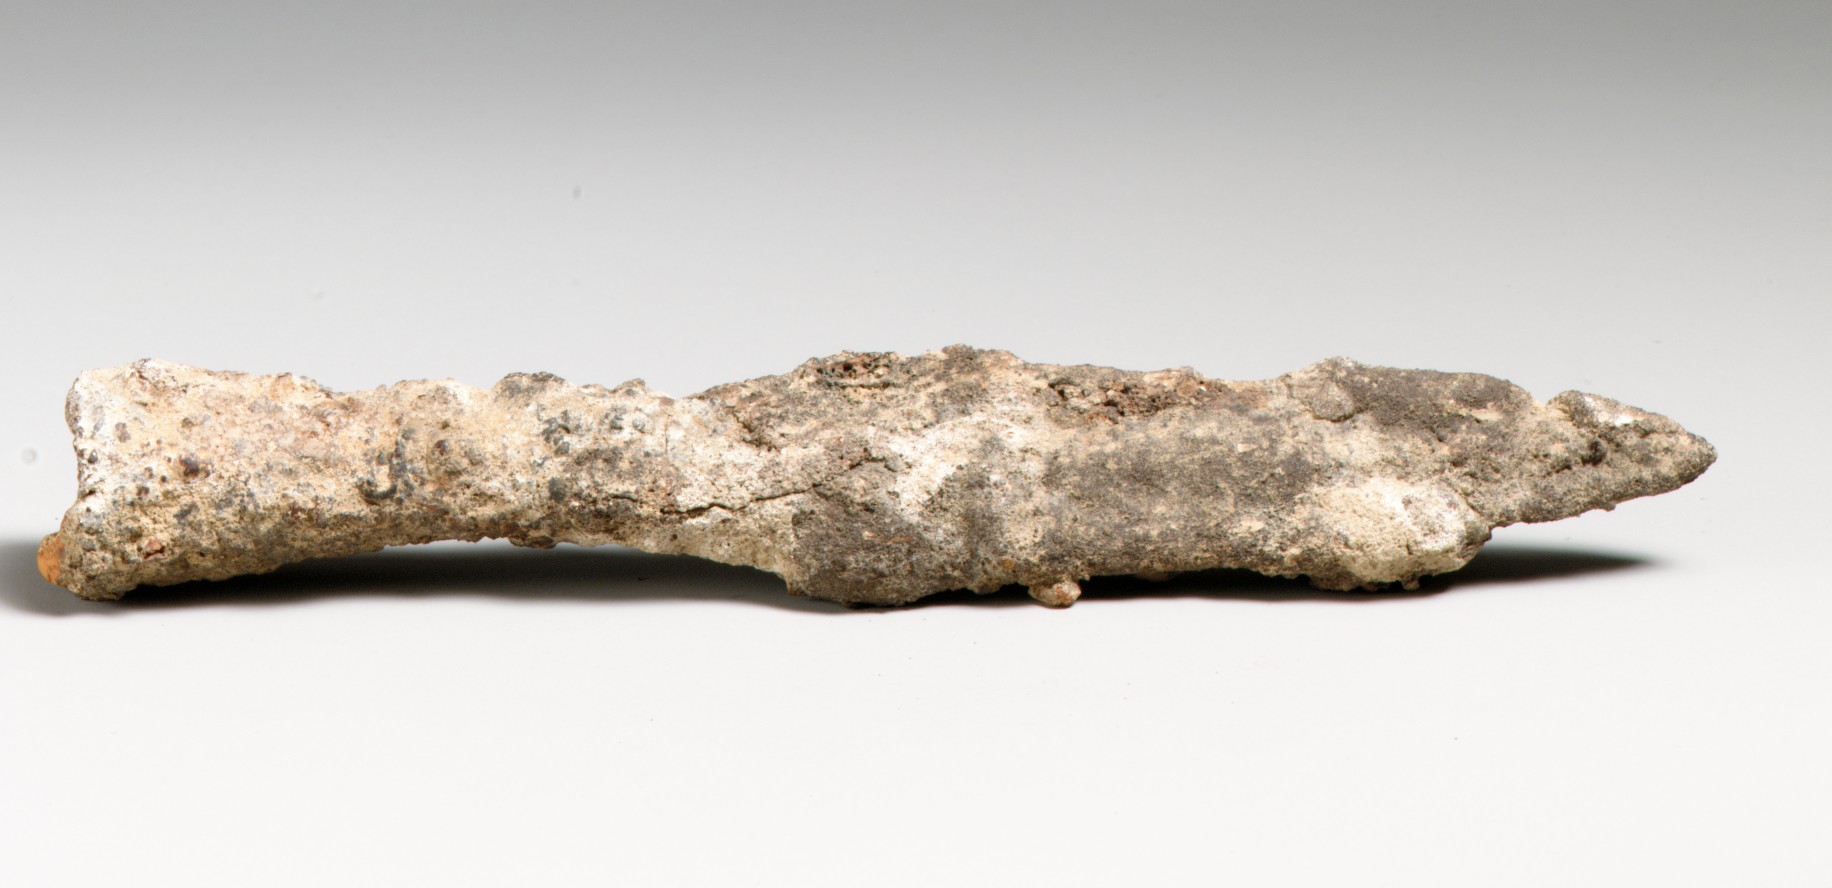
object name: spearhead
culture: cypriot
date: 1050-1000 BCE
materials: iron